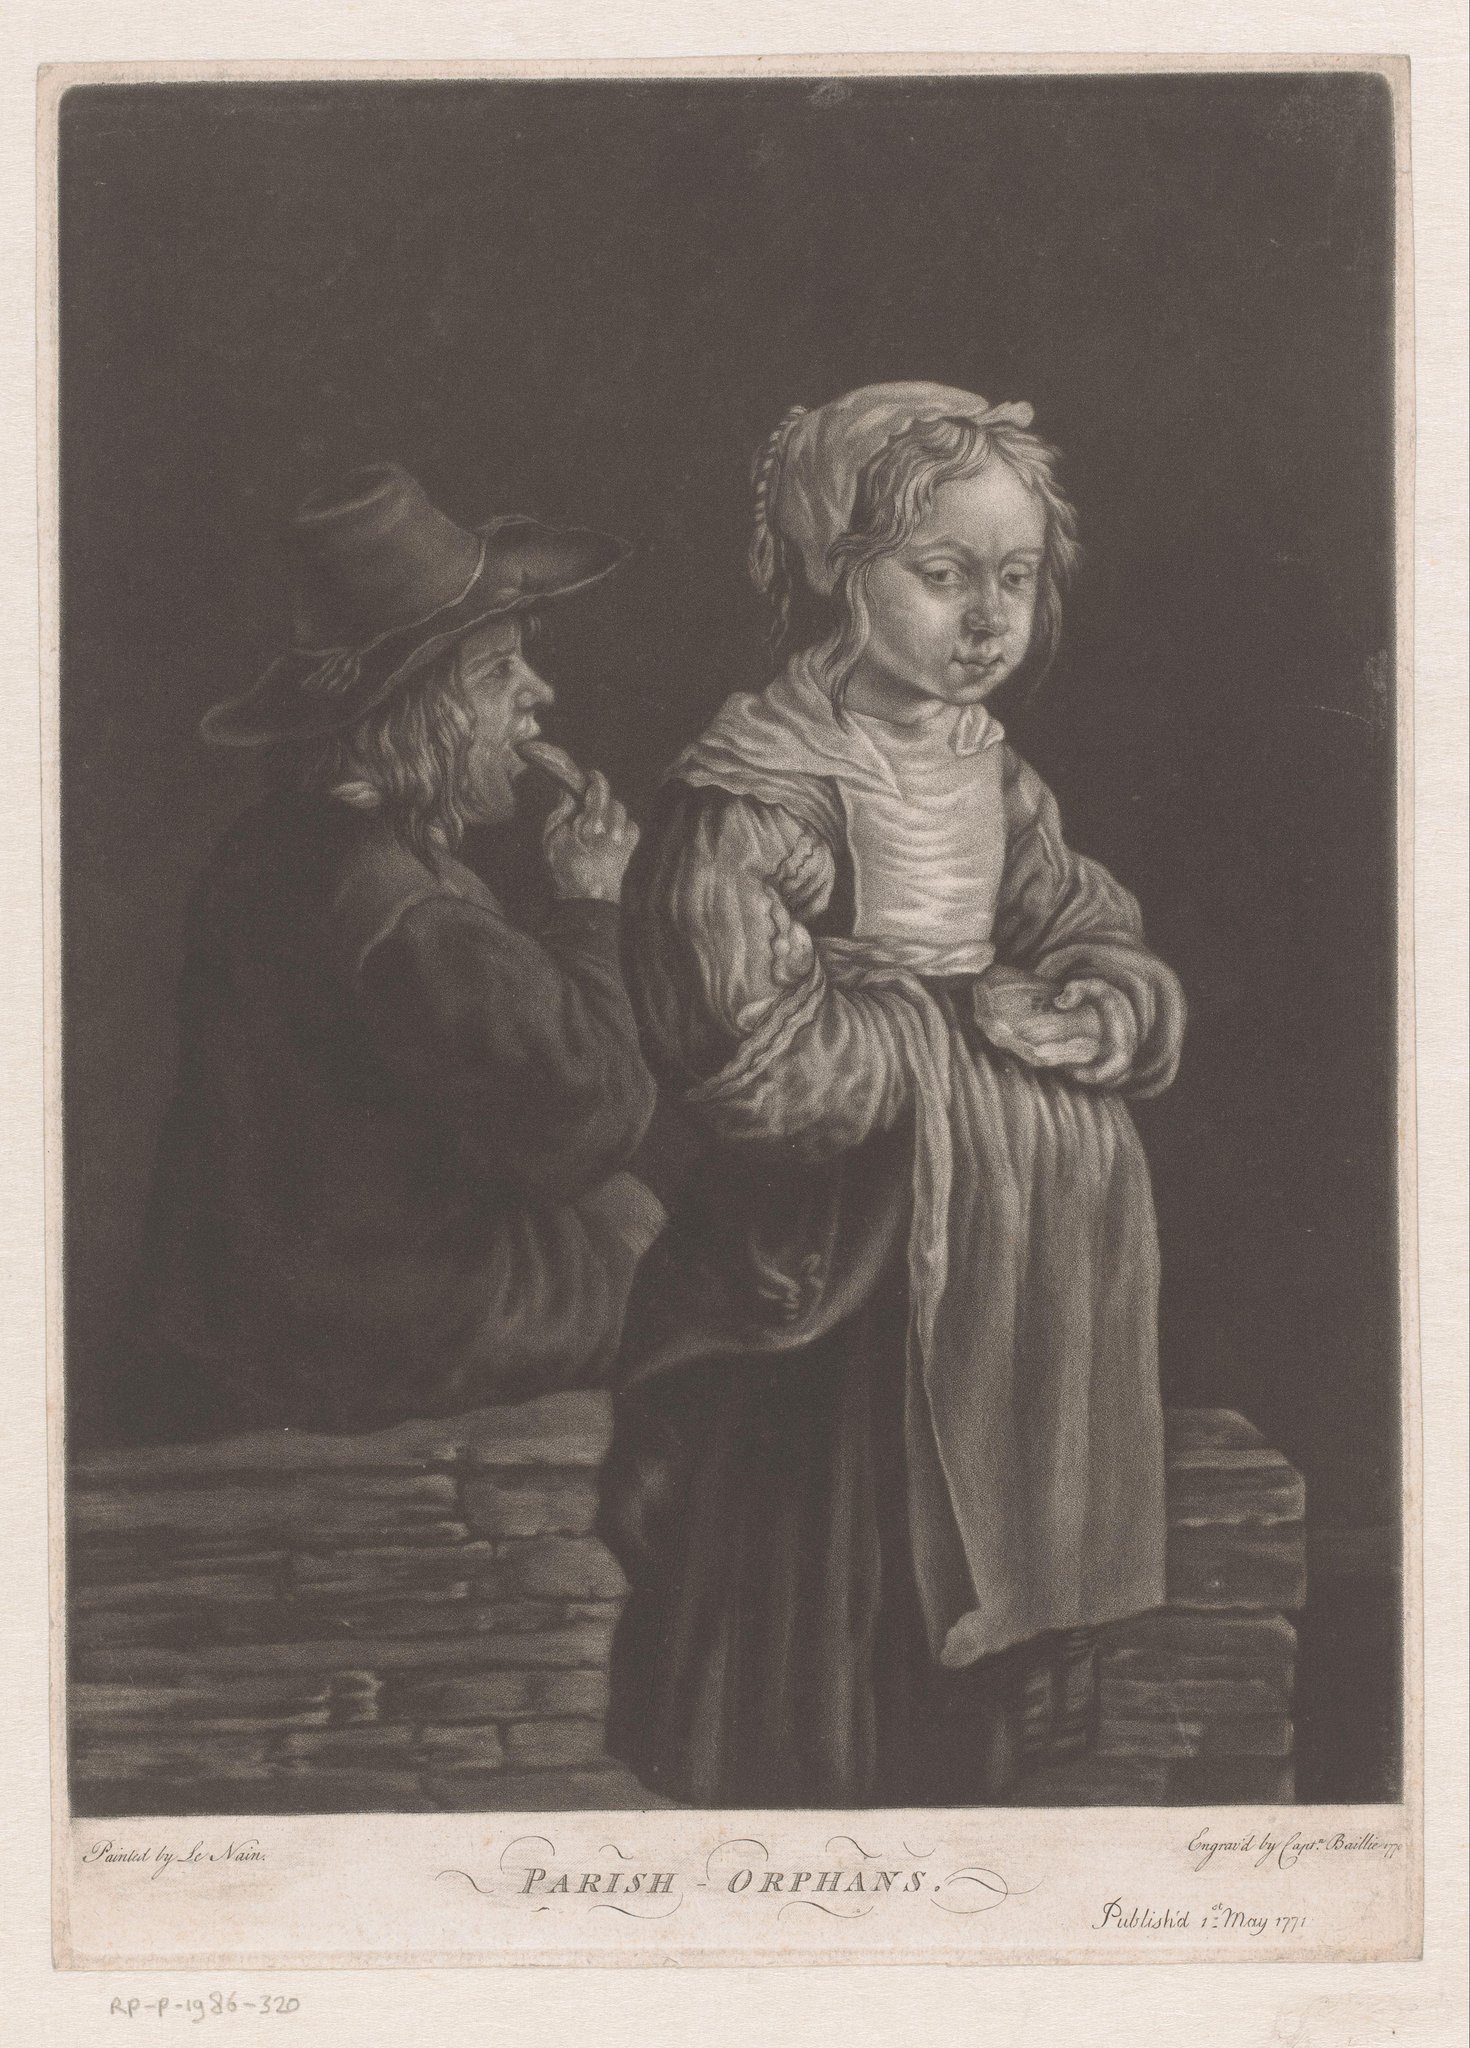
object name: print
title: Twee weeskinderen met stuk brood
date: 1770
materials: paper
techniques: mezzotint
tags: bread, loaf, orphans, eating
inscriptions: collector's mark: Lugt 2228, collector's mark: Lugt 2760